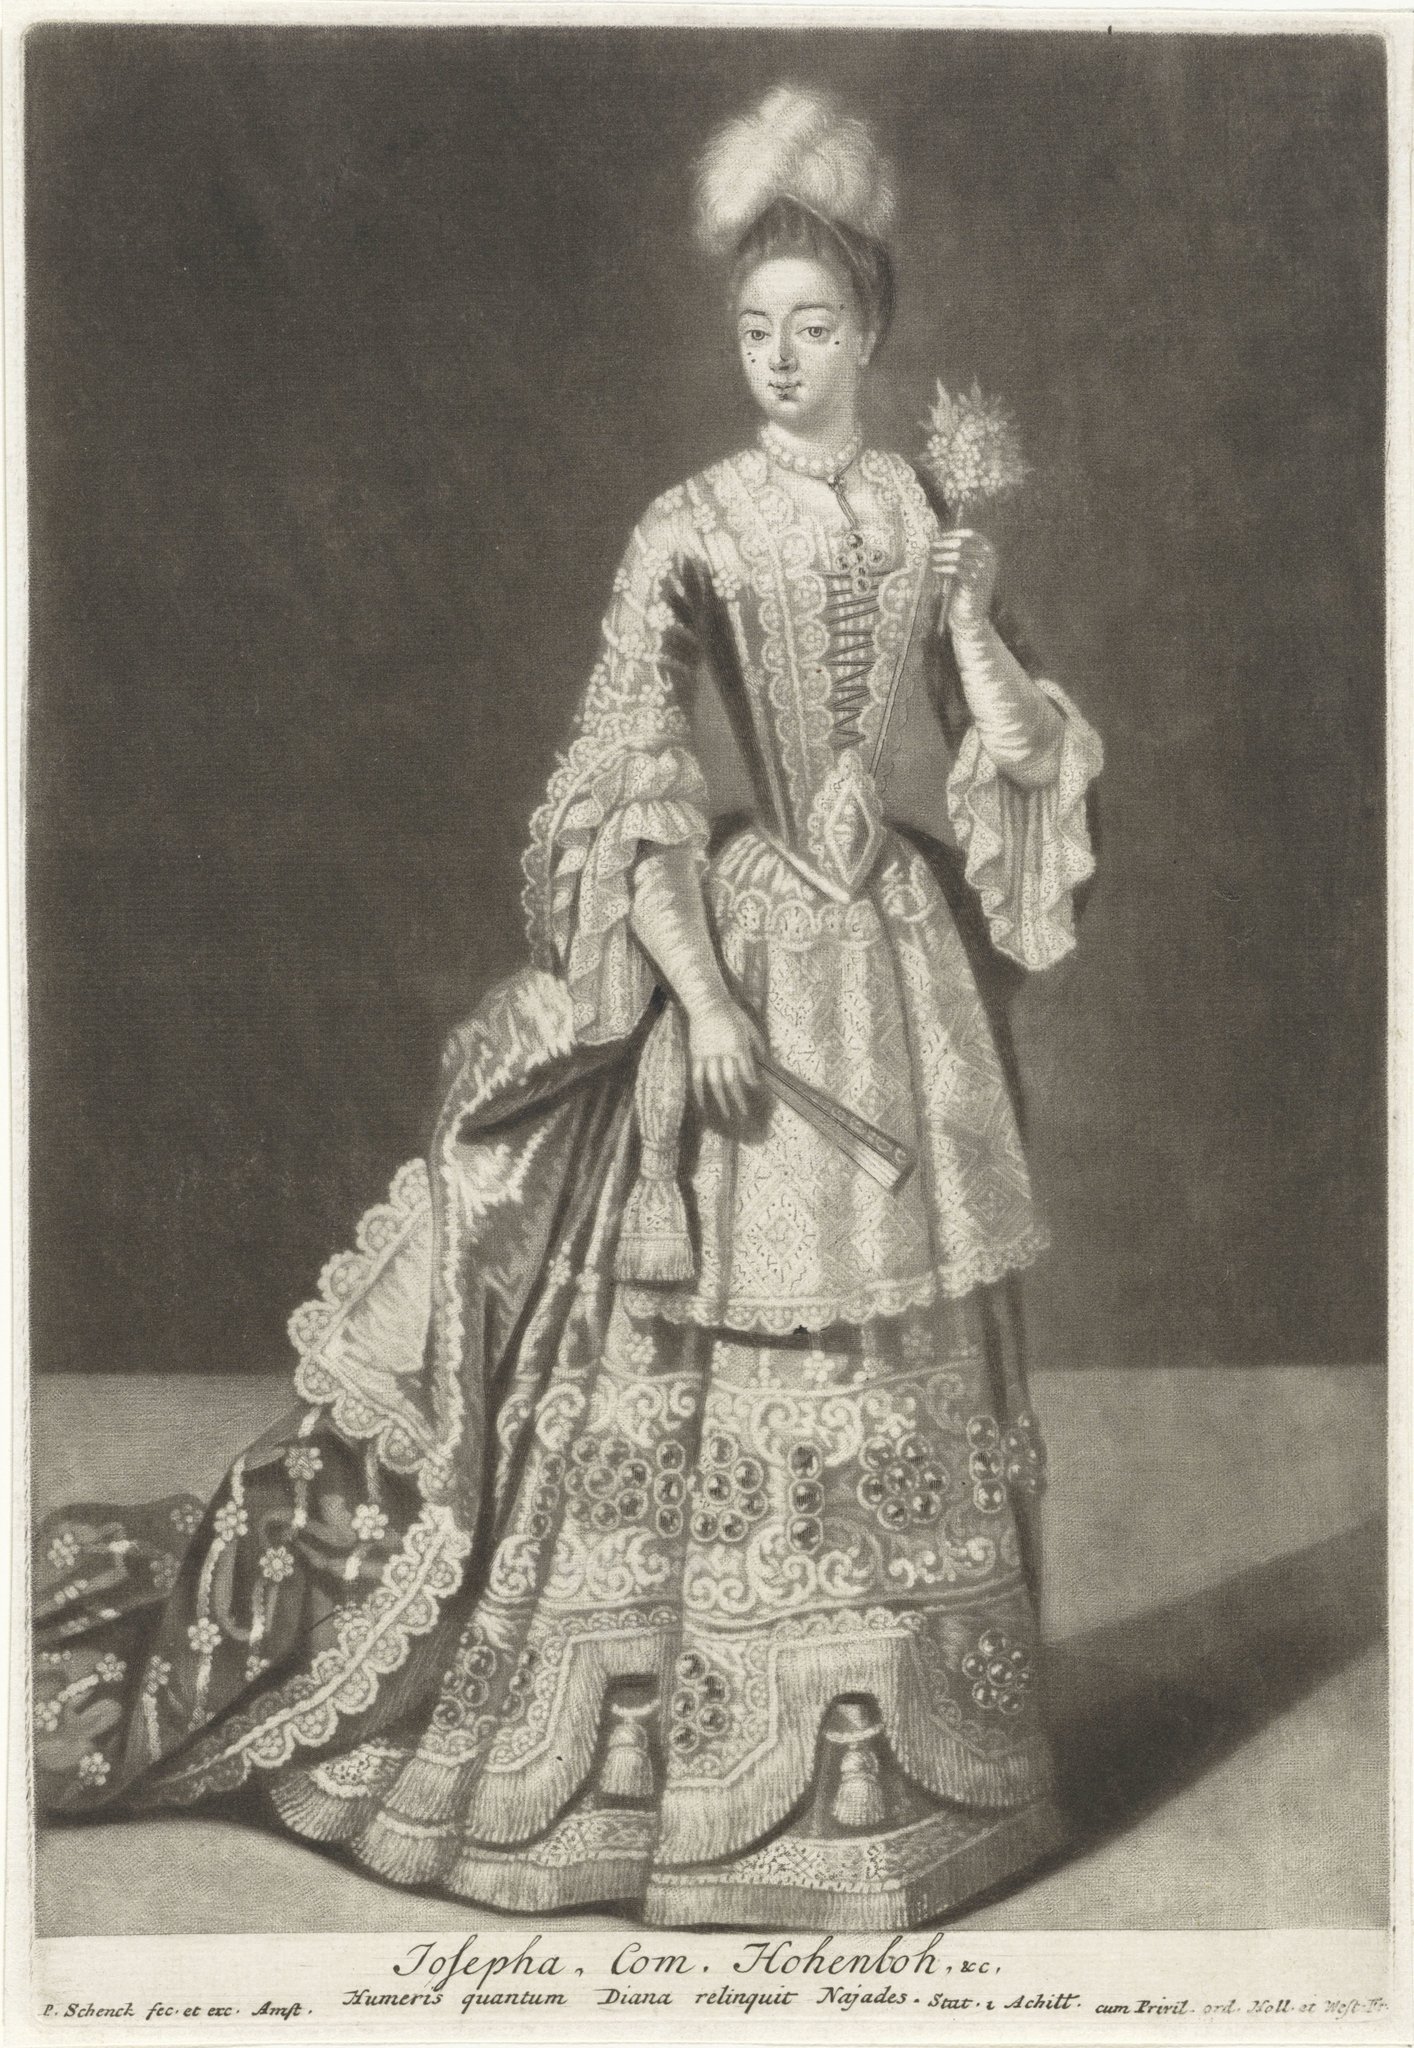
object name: print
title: Portret van Anna Josepha gravin van Hohenlohe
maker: pieter schenk (i)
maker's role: print maker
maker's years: 1660-1711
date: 1670-1713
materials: paper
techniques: engraving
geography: amsterdam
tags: cut flowers; nosegay, bunch of flowers, fan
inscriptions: collector's mark: Lugt 2228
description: Anna Josepha, gravin van Hohenlohe, met in de hand een waaier en een bloem.